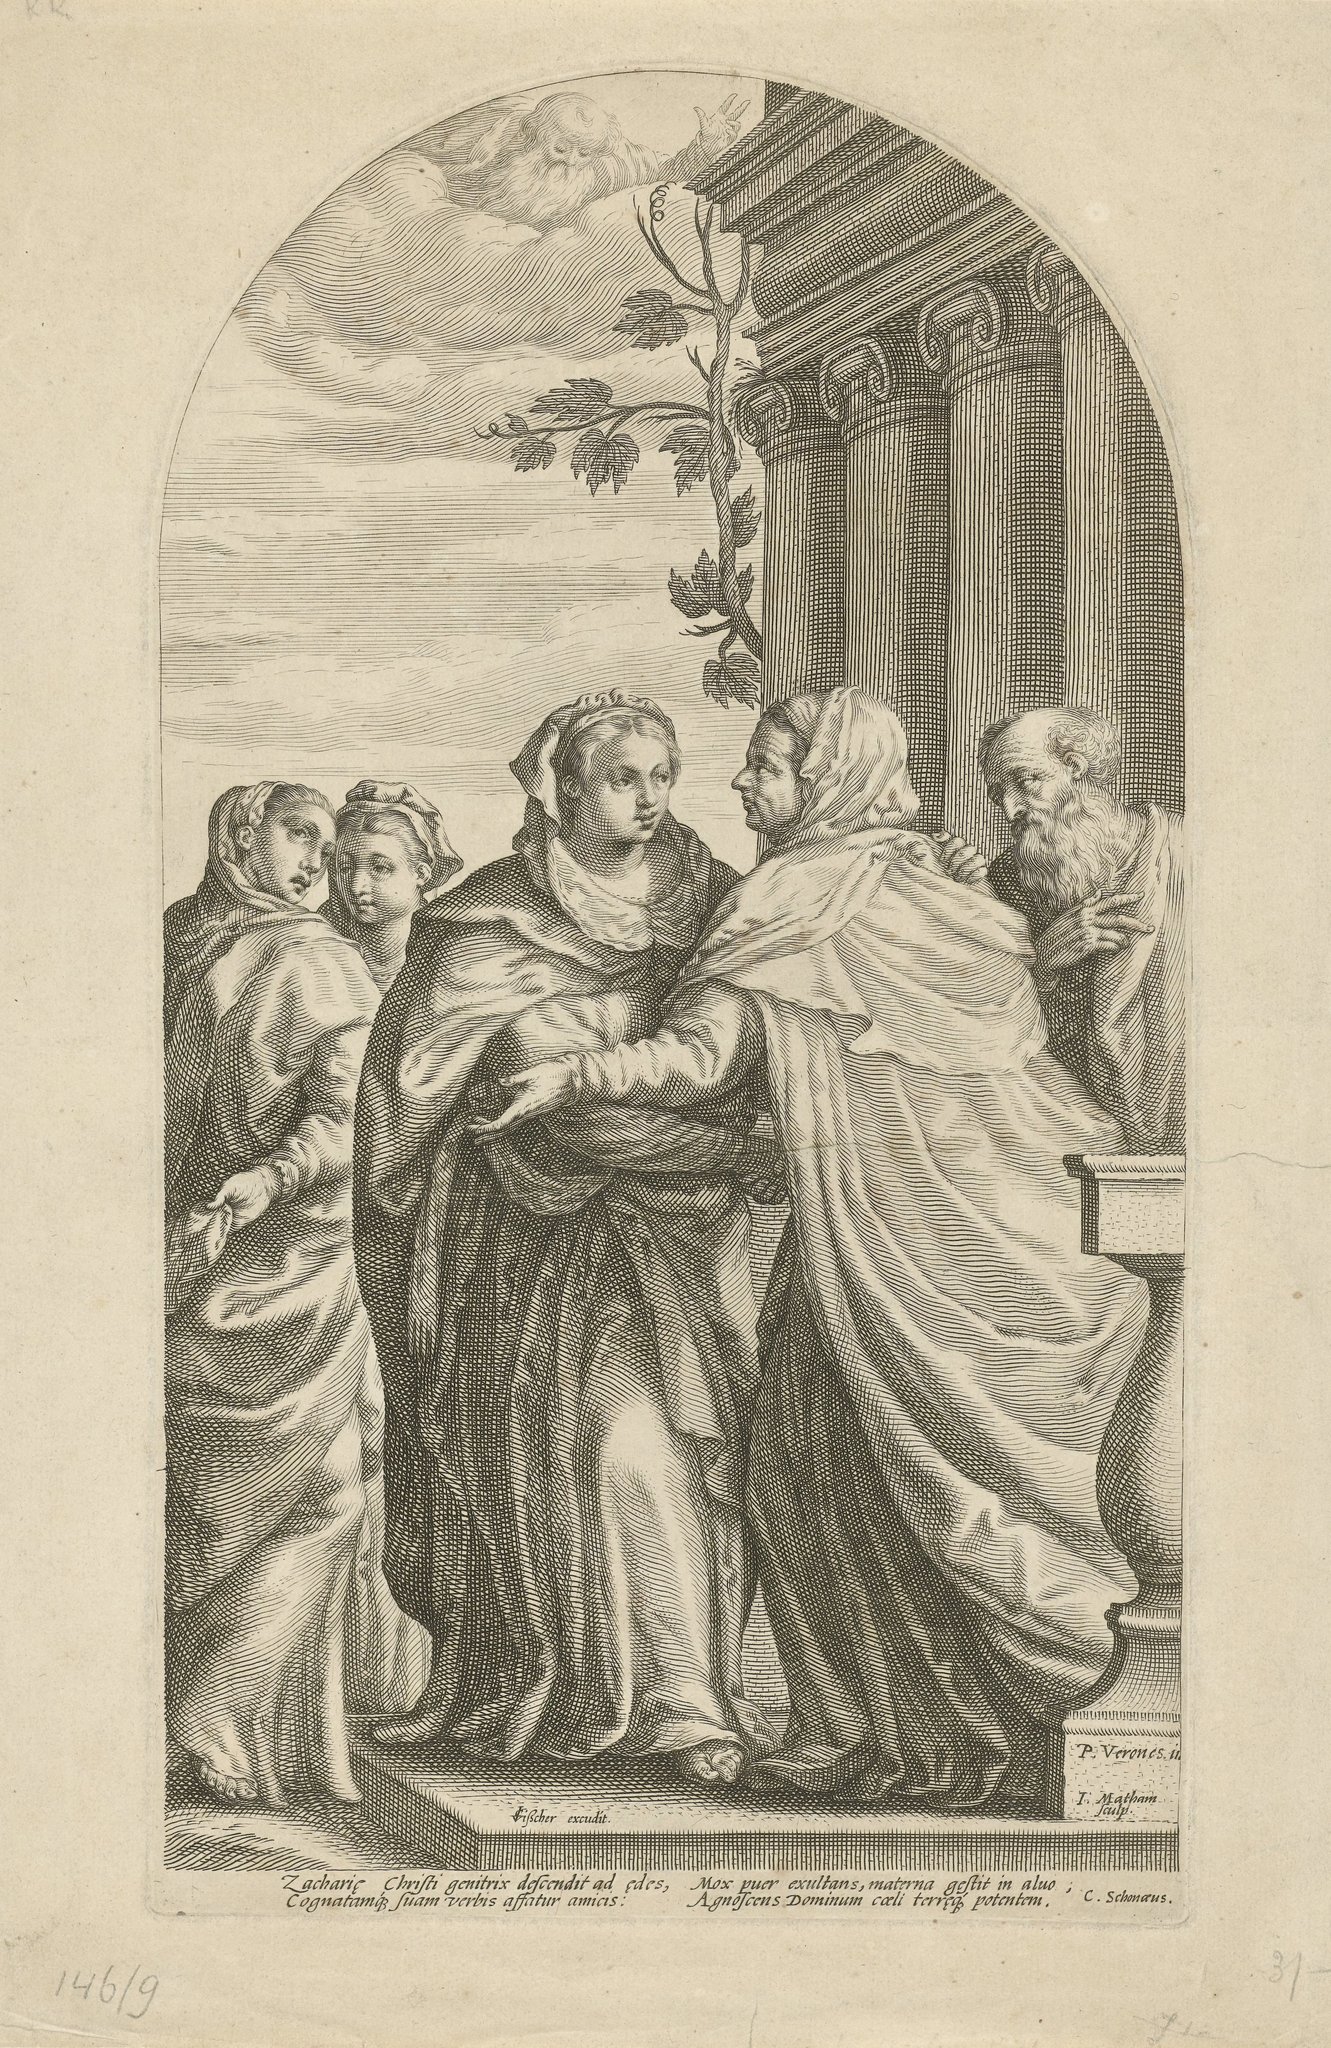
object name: print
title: Visitatie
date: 1592-1596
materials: paper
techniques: engraving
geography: haarlem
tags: mary and elisabeth shaking hands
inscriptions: collector's mark: Lugt 2228